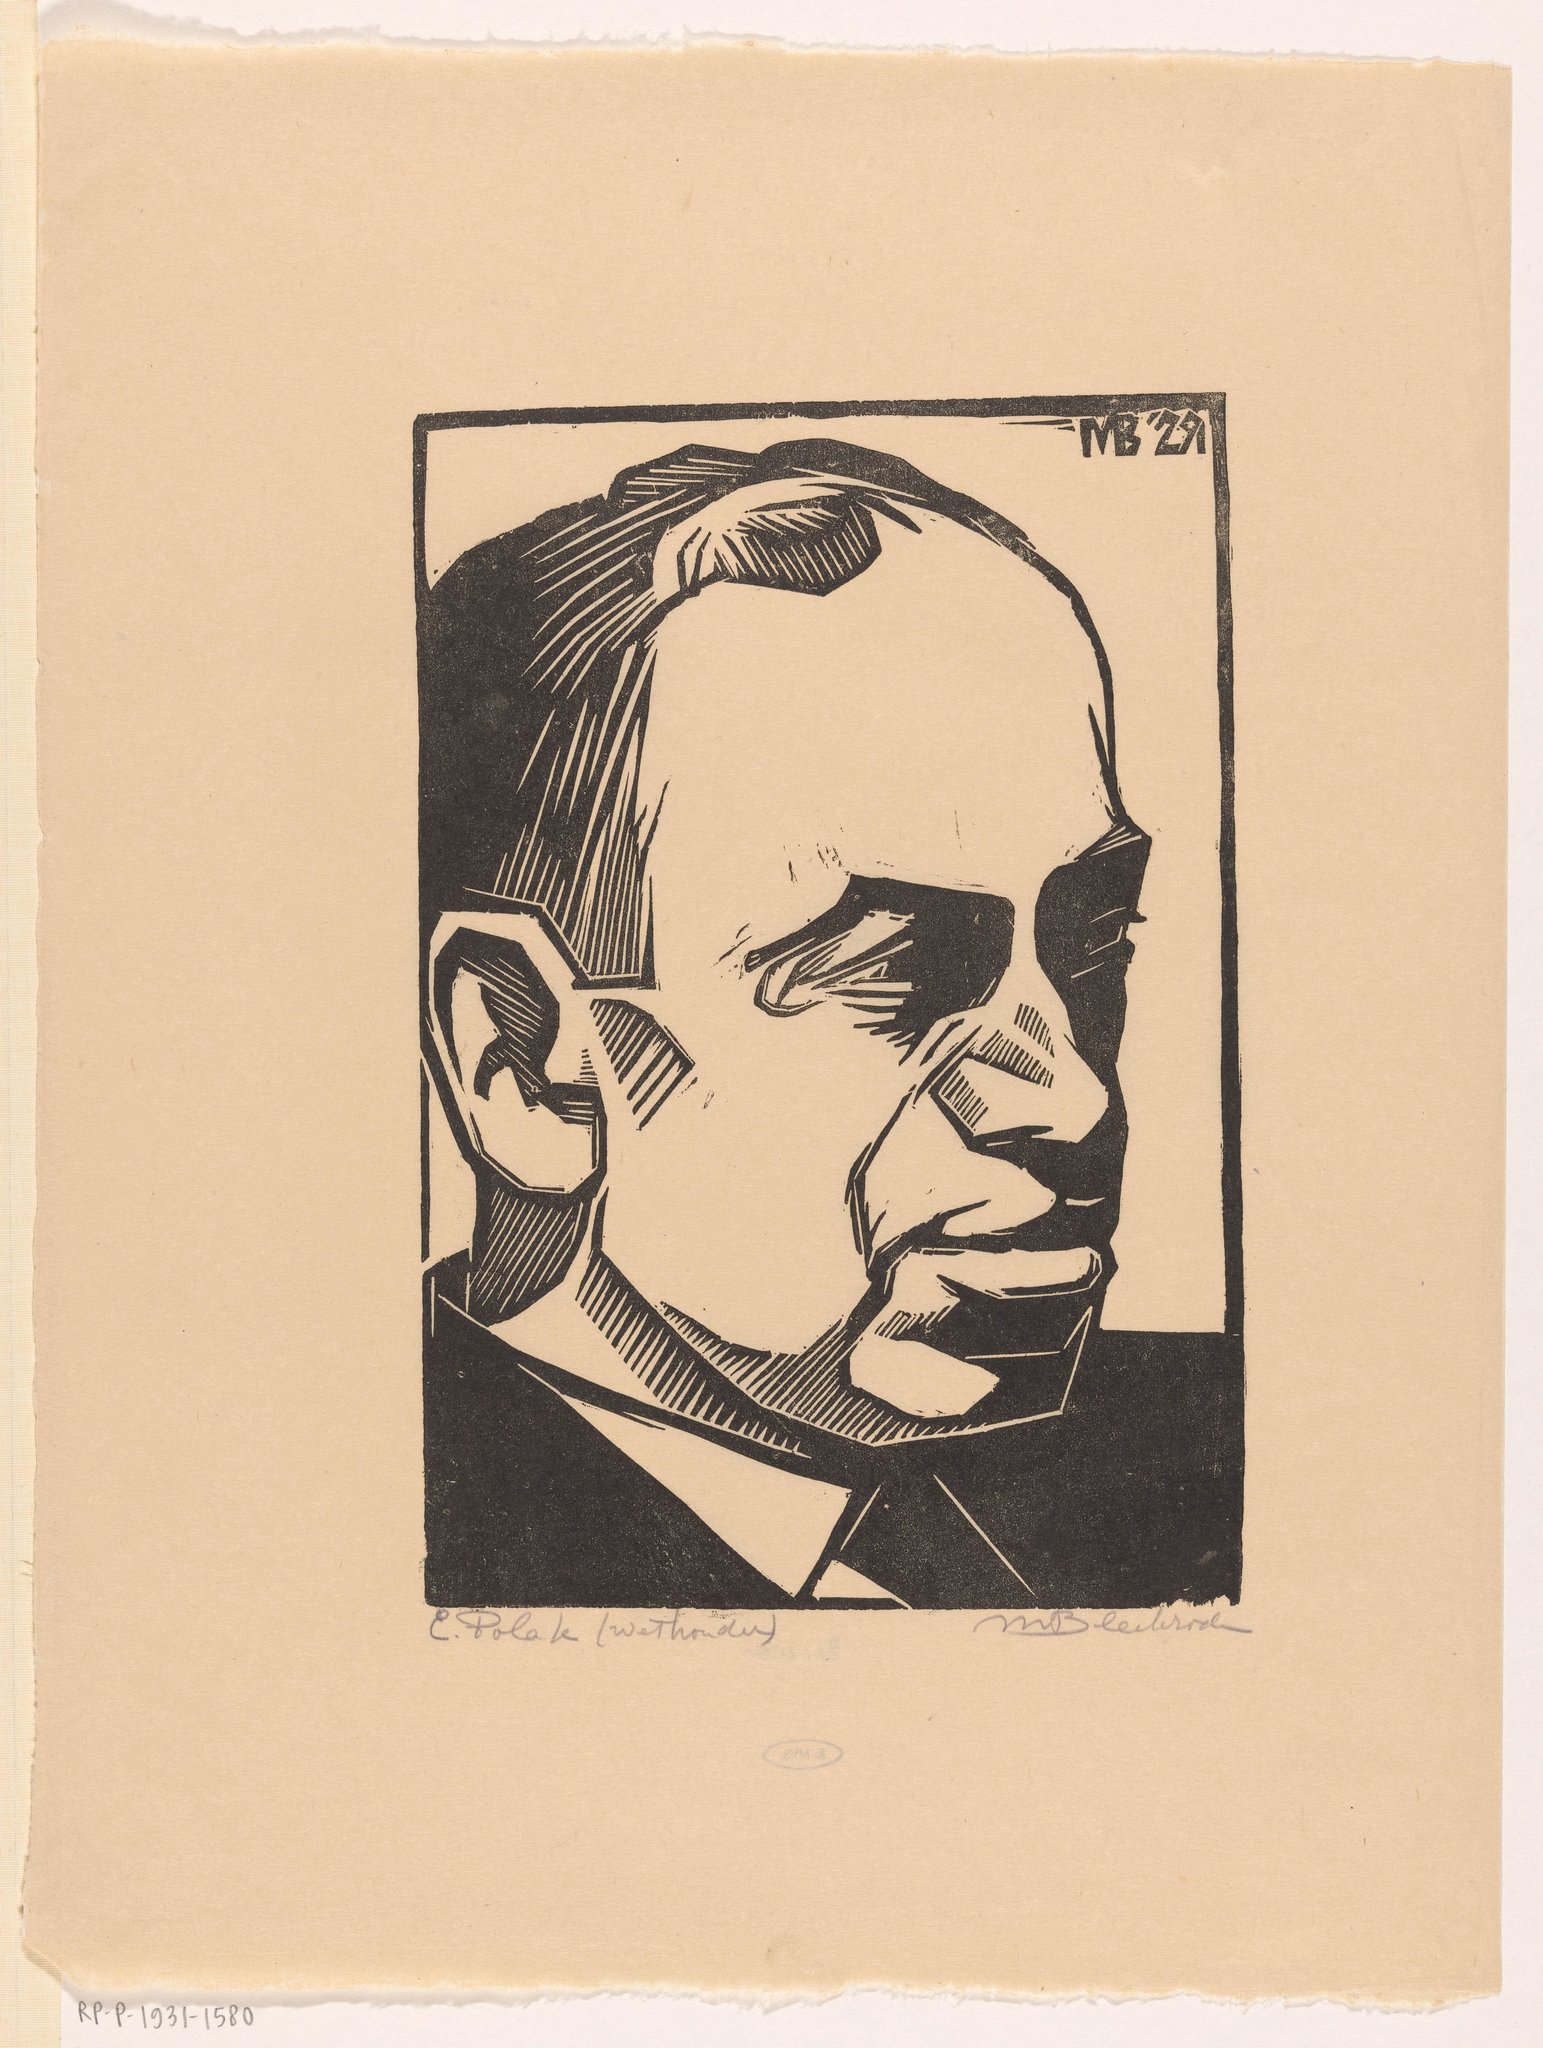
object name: print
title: Portret van Eliazer Polak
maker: meijer bleekrode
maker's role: draughtsman, painter, print maker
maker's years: 1896-1943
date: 1929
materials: paper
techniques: woodcut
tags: politician, politician, e.g. party leader, historical persons (portraits and scenes from the life)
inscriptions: collector's mark: Lugt 2228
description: Portret van de Amsterdamse SDAP-wethouder Eliazer (Eidje) Polak.